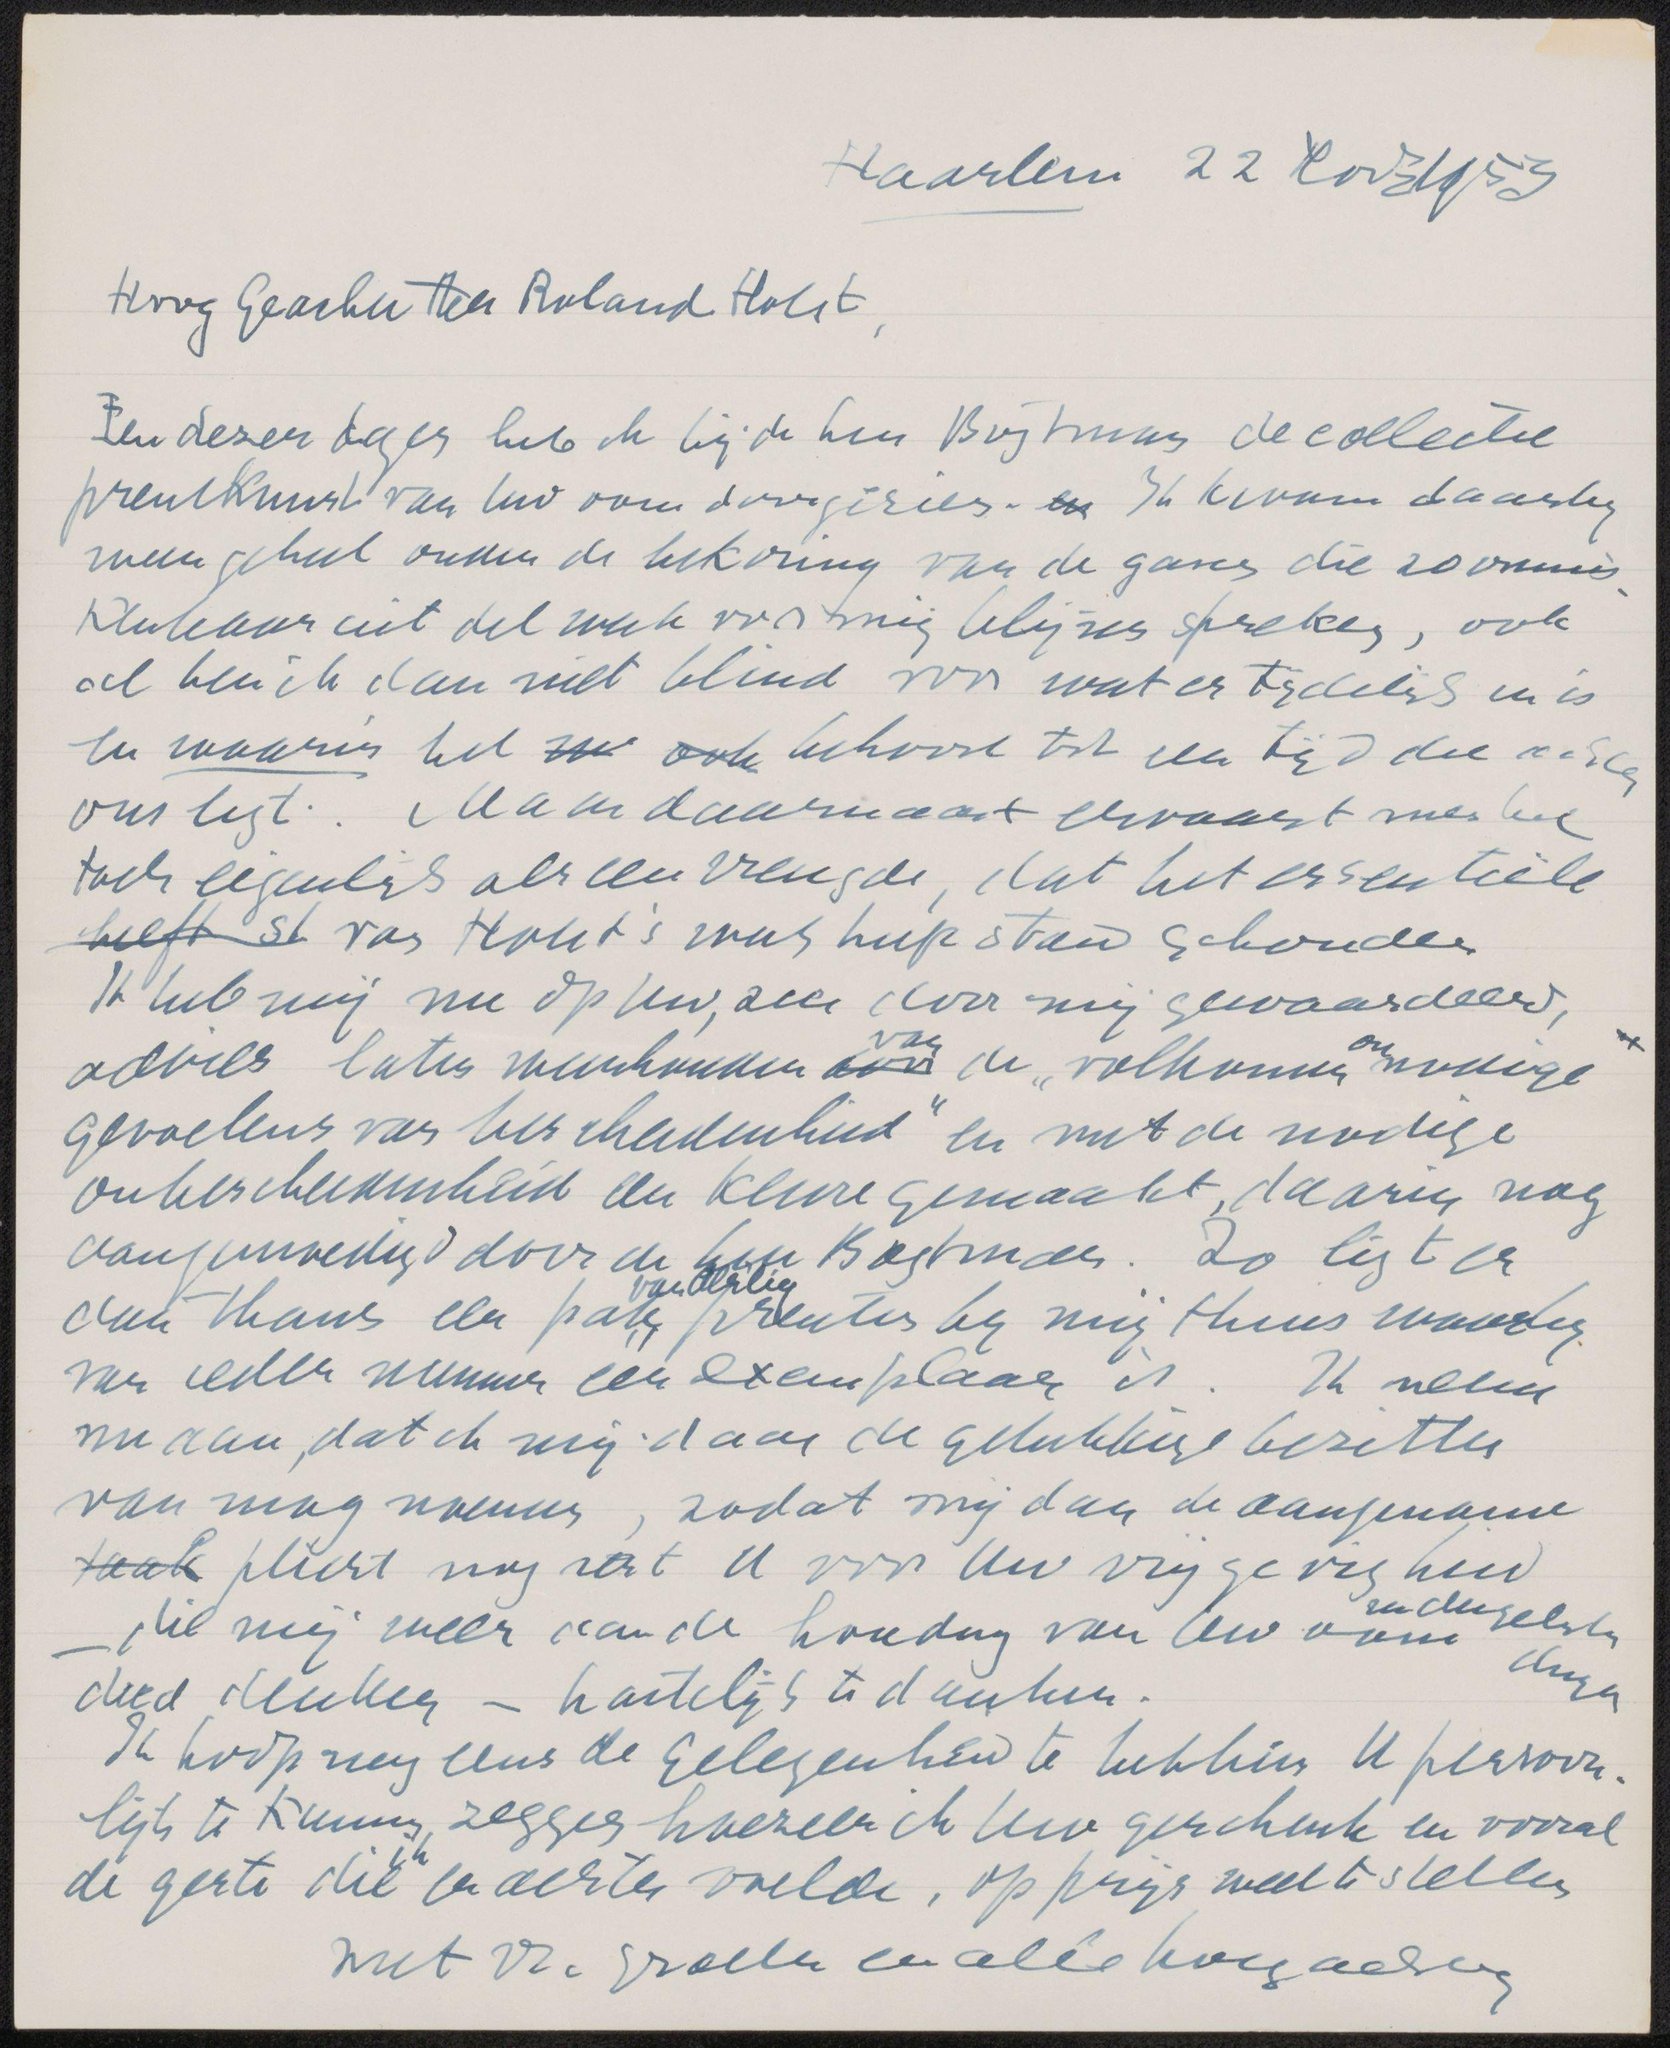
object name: letter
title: Brief aan Richard Roland Holst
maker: a. van der boom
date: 1953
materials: ink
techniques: pen, writing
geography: haarlem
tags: haarlem, willem bogtman, richard nicolaüs roland holst, the graphic arts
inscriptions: collector's mark: Lugt L.2228a